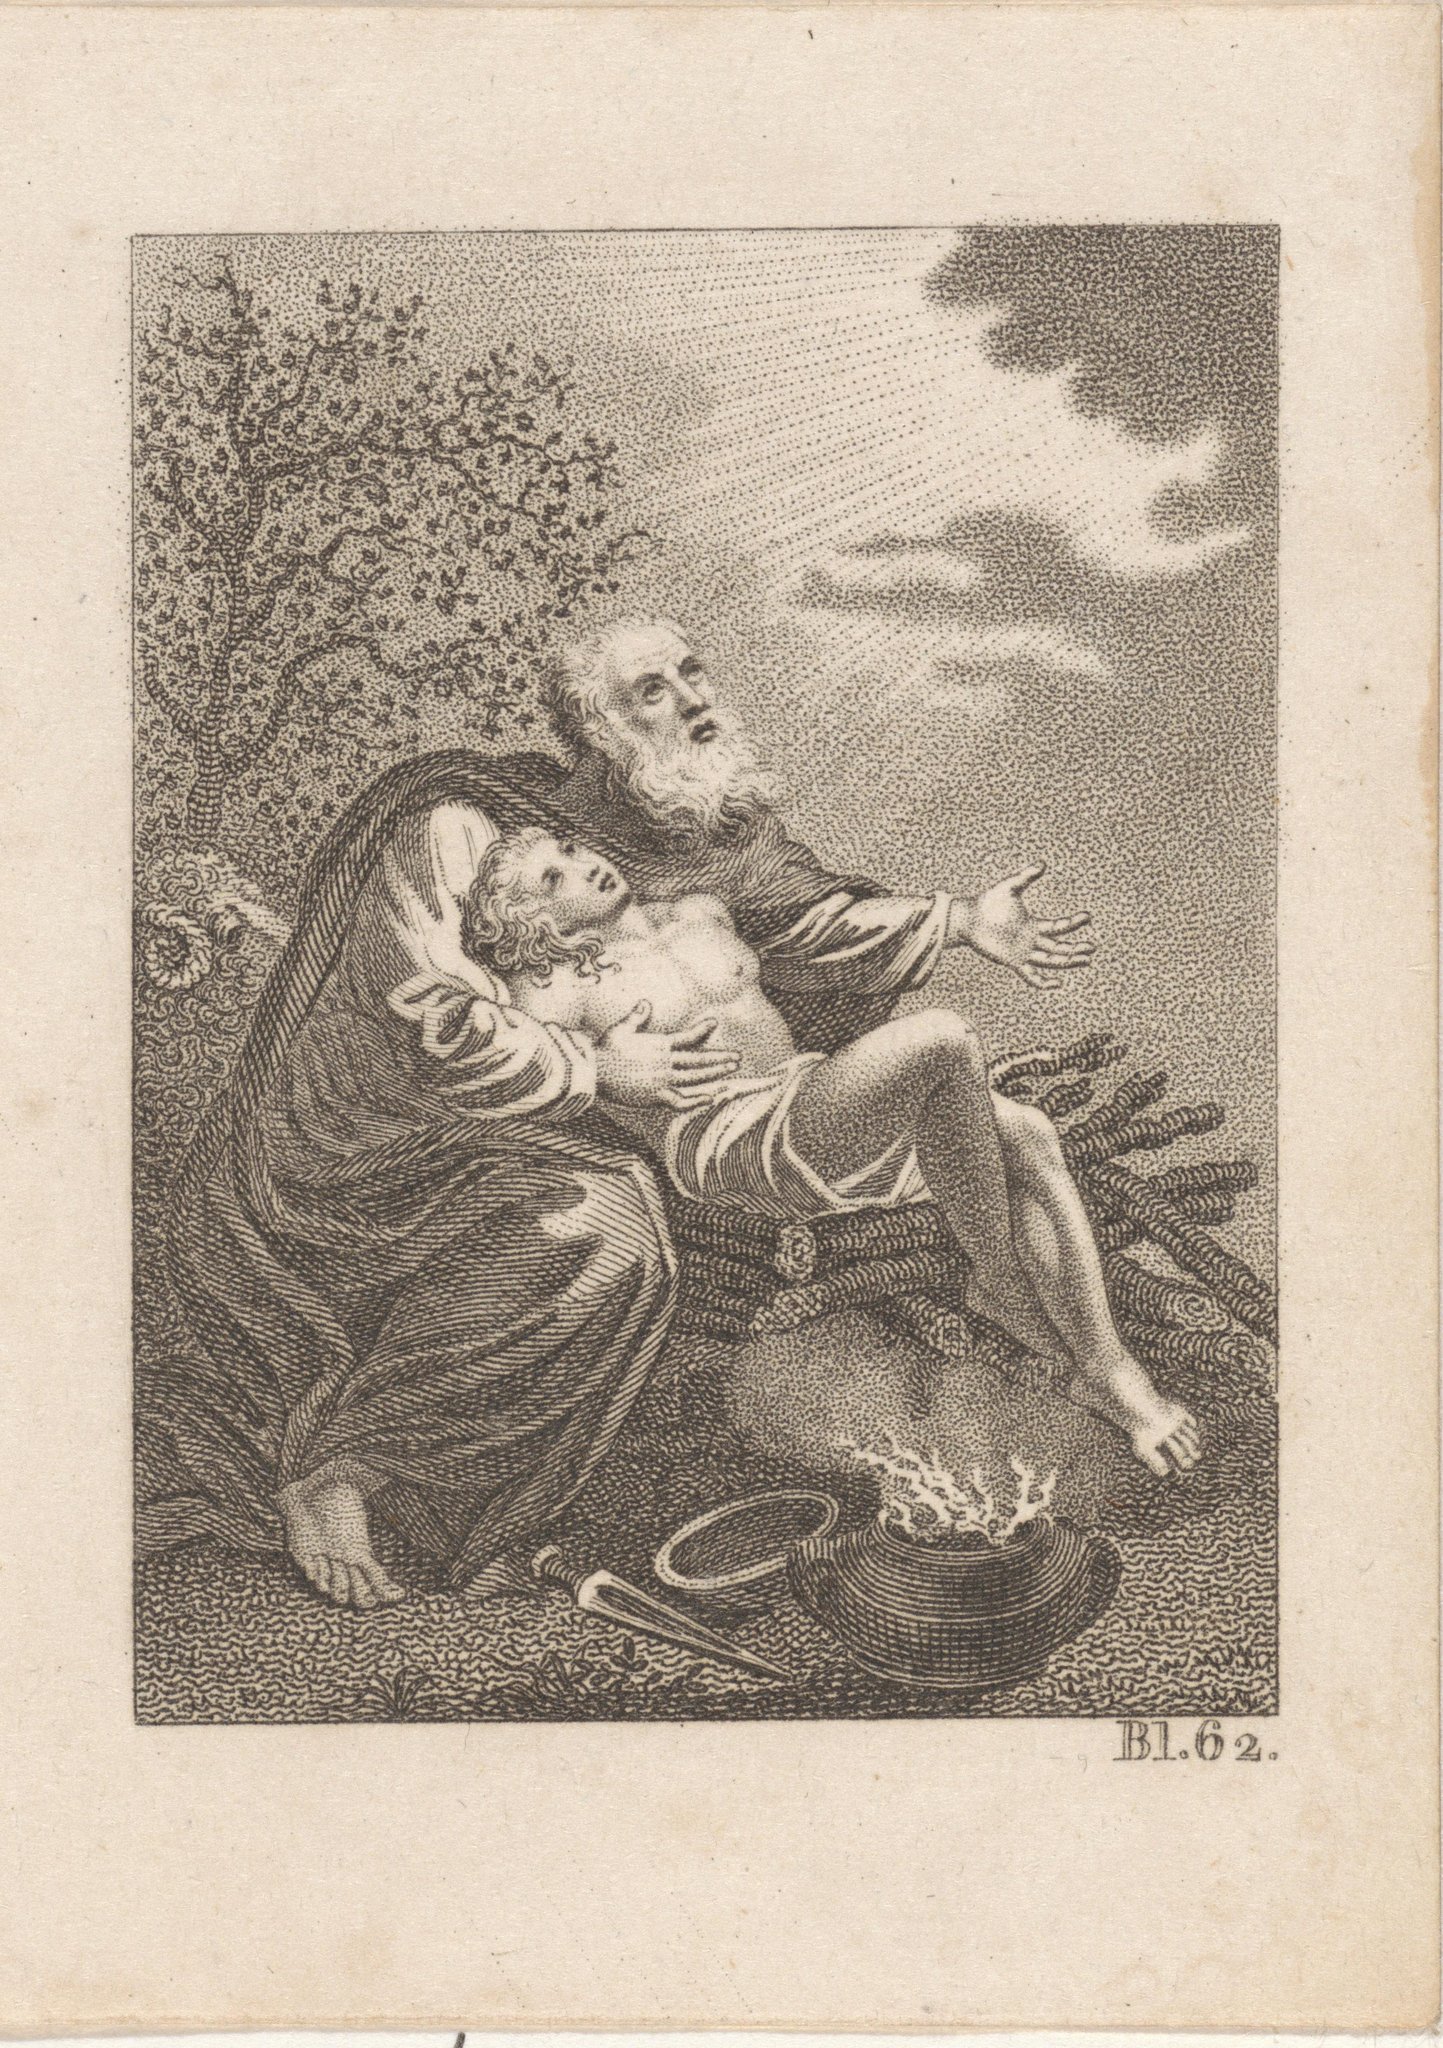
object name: book illustration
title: Offer van Isaak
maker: philippus velijn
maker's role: print maker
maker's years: 1787-1836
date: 1821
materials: paper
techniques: etching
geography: netherlands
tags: the sacrifice of isaac (genesis 22)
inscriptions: collector's mark: Lugt 2228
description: Prent gebruikt als boekillustratie in: Almanak aan bevalligheid en deugd gewijd. Amsterdam: M. Westerman, 1821.